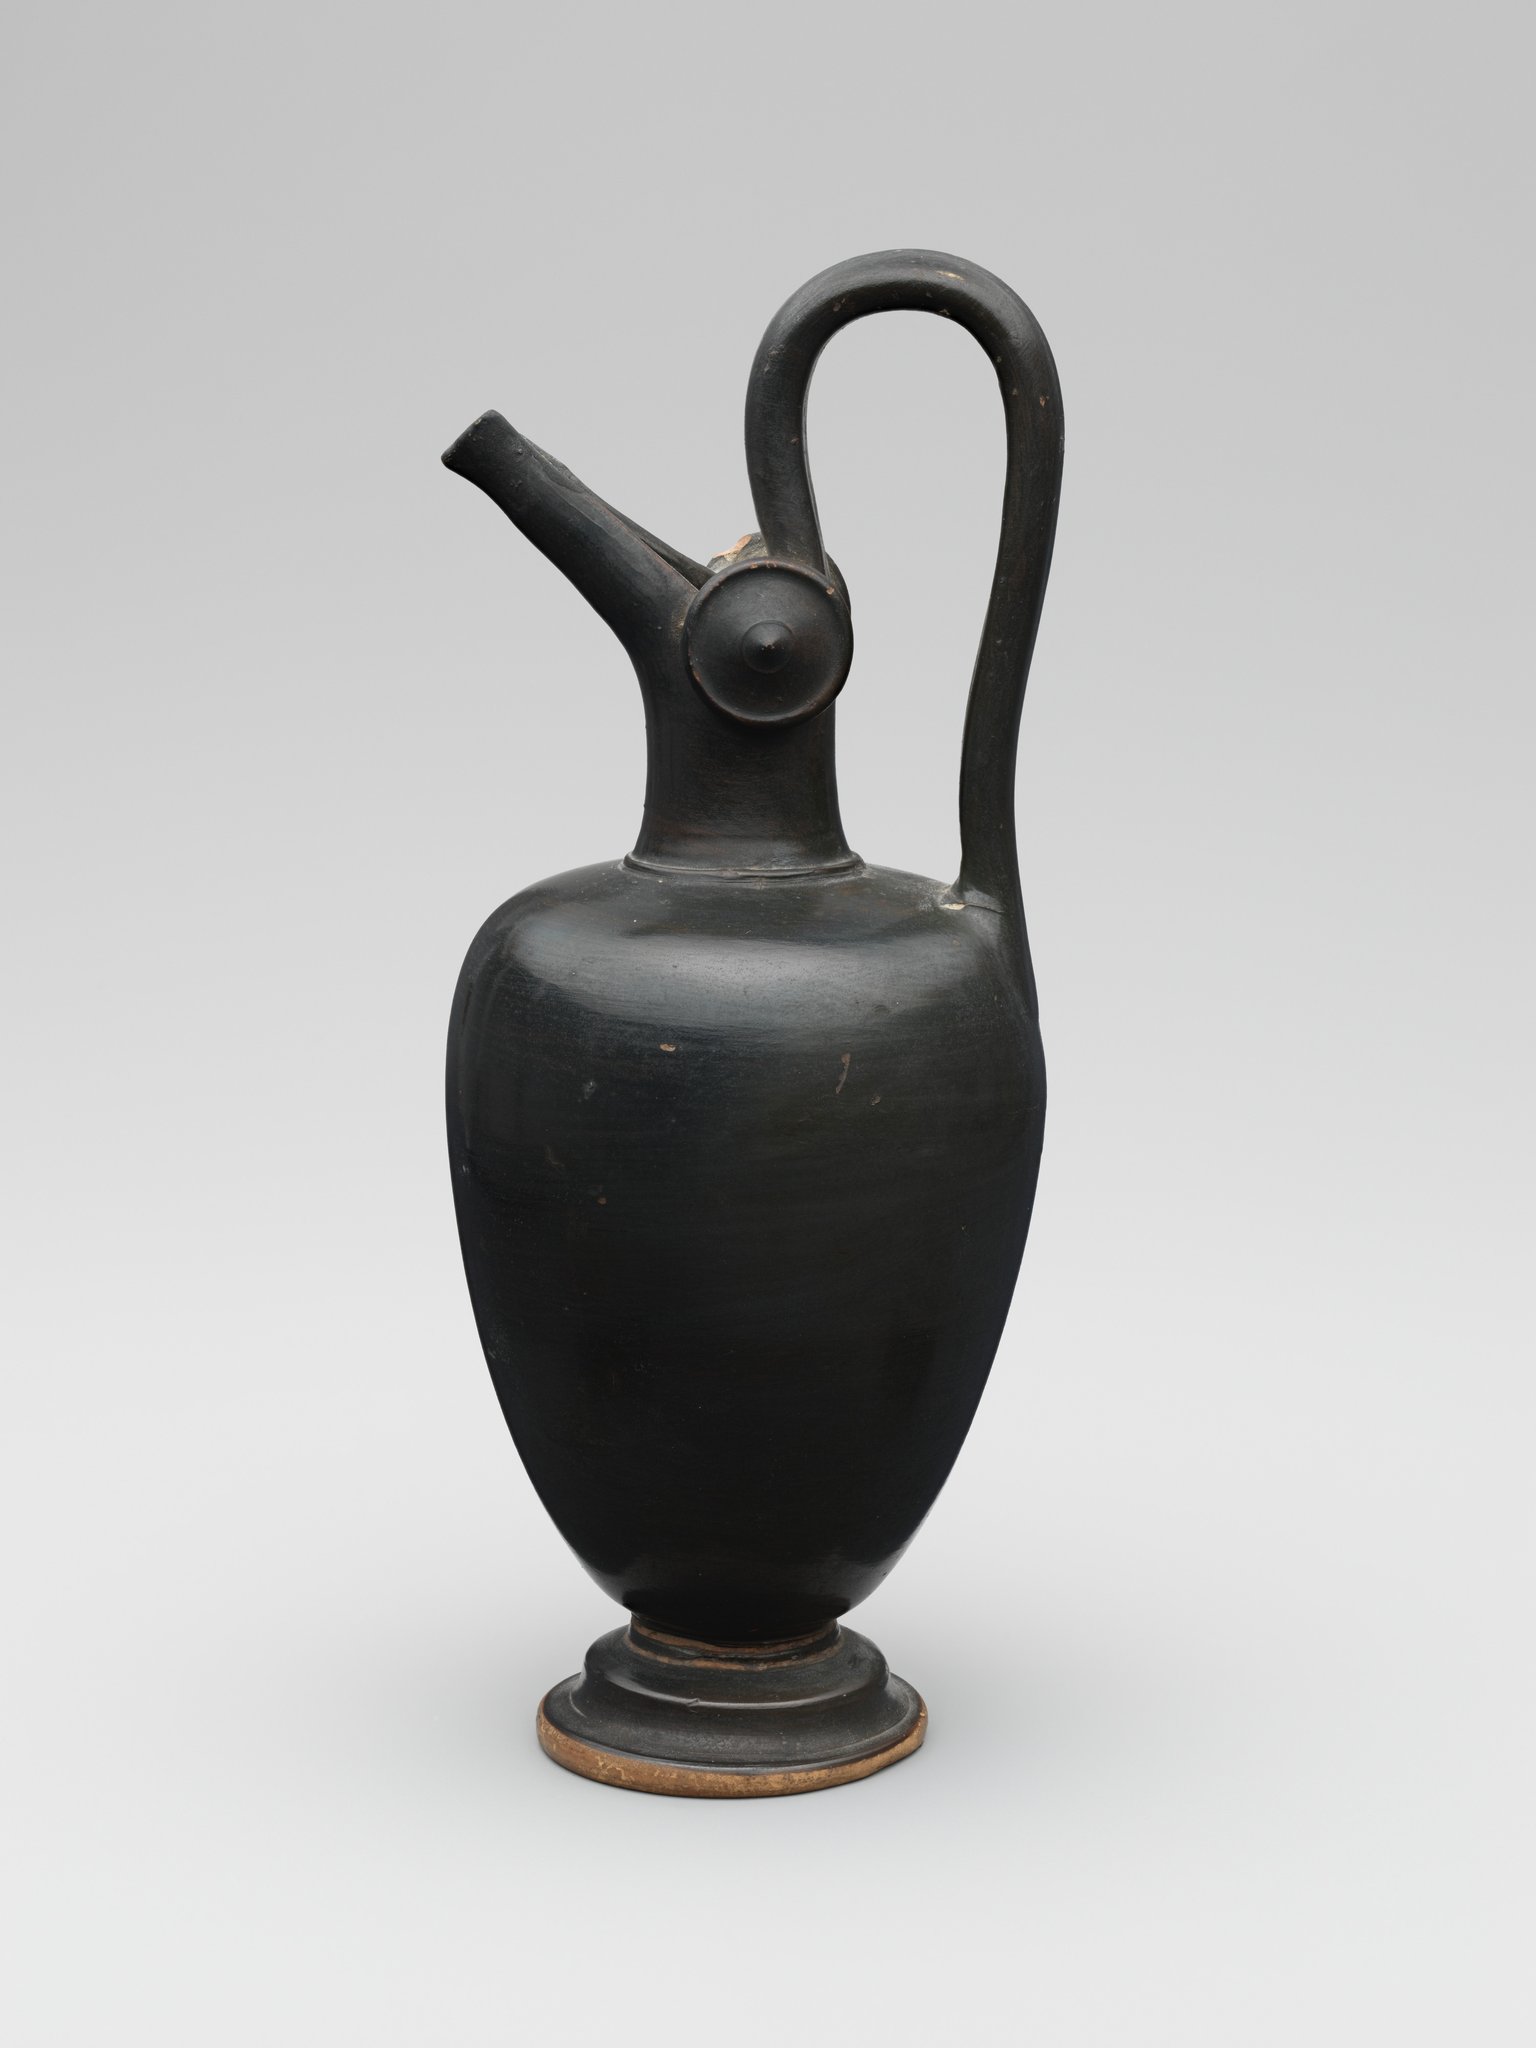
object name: oinochoe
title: Terracotta oinochoe (jug)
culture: greek, attic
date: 434-401 BCE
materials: terracotta